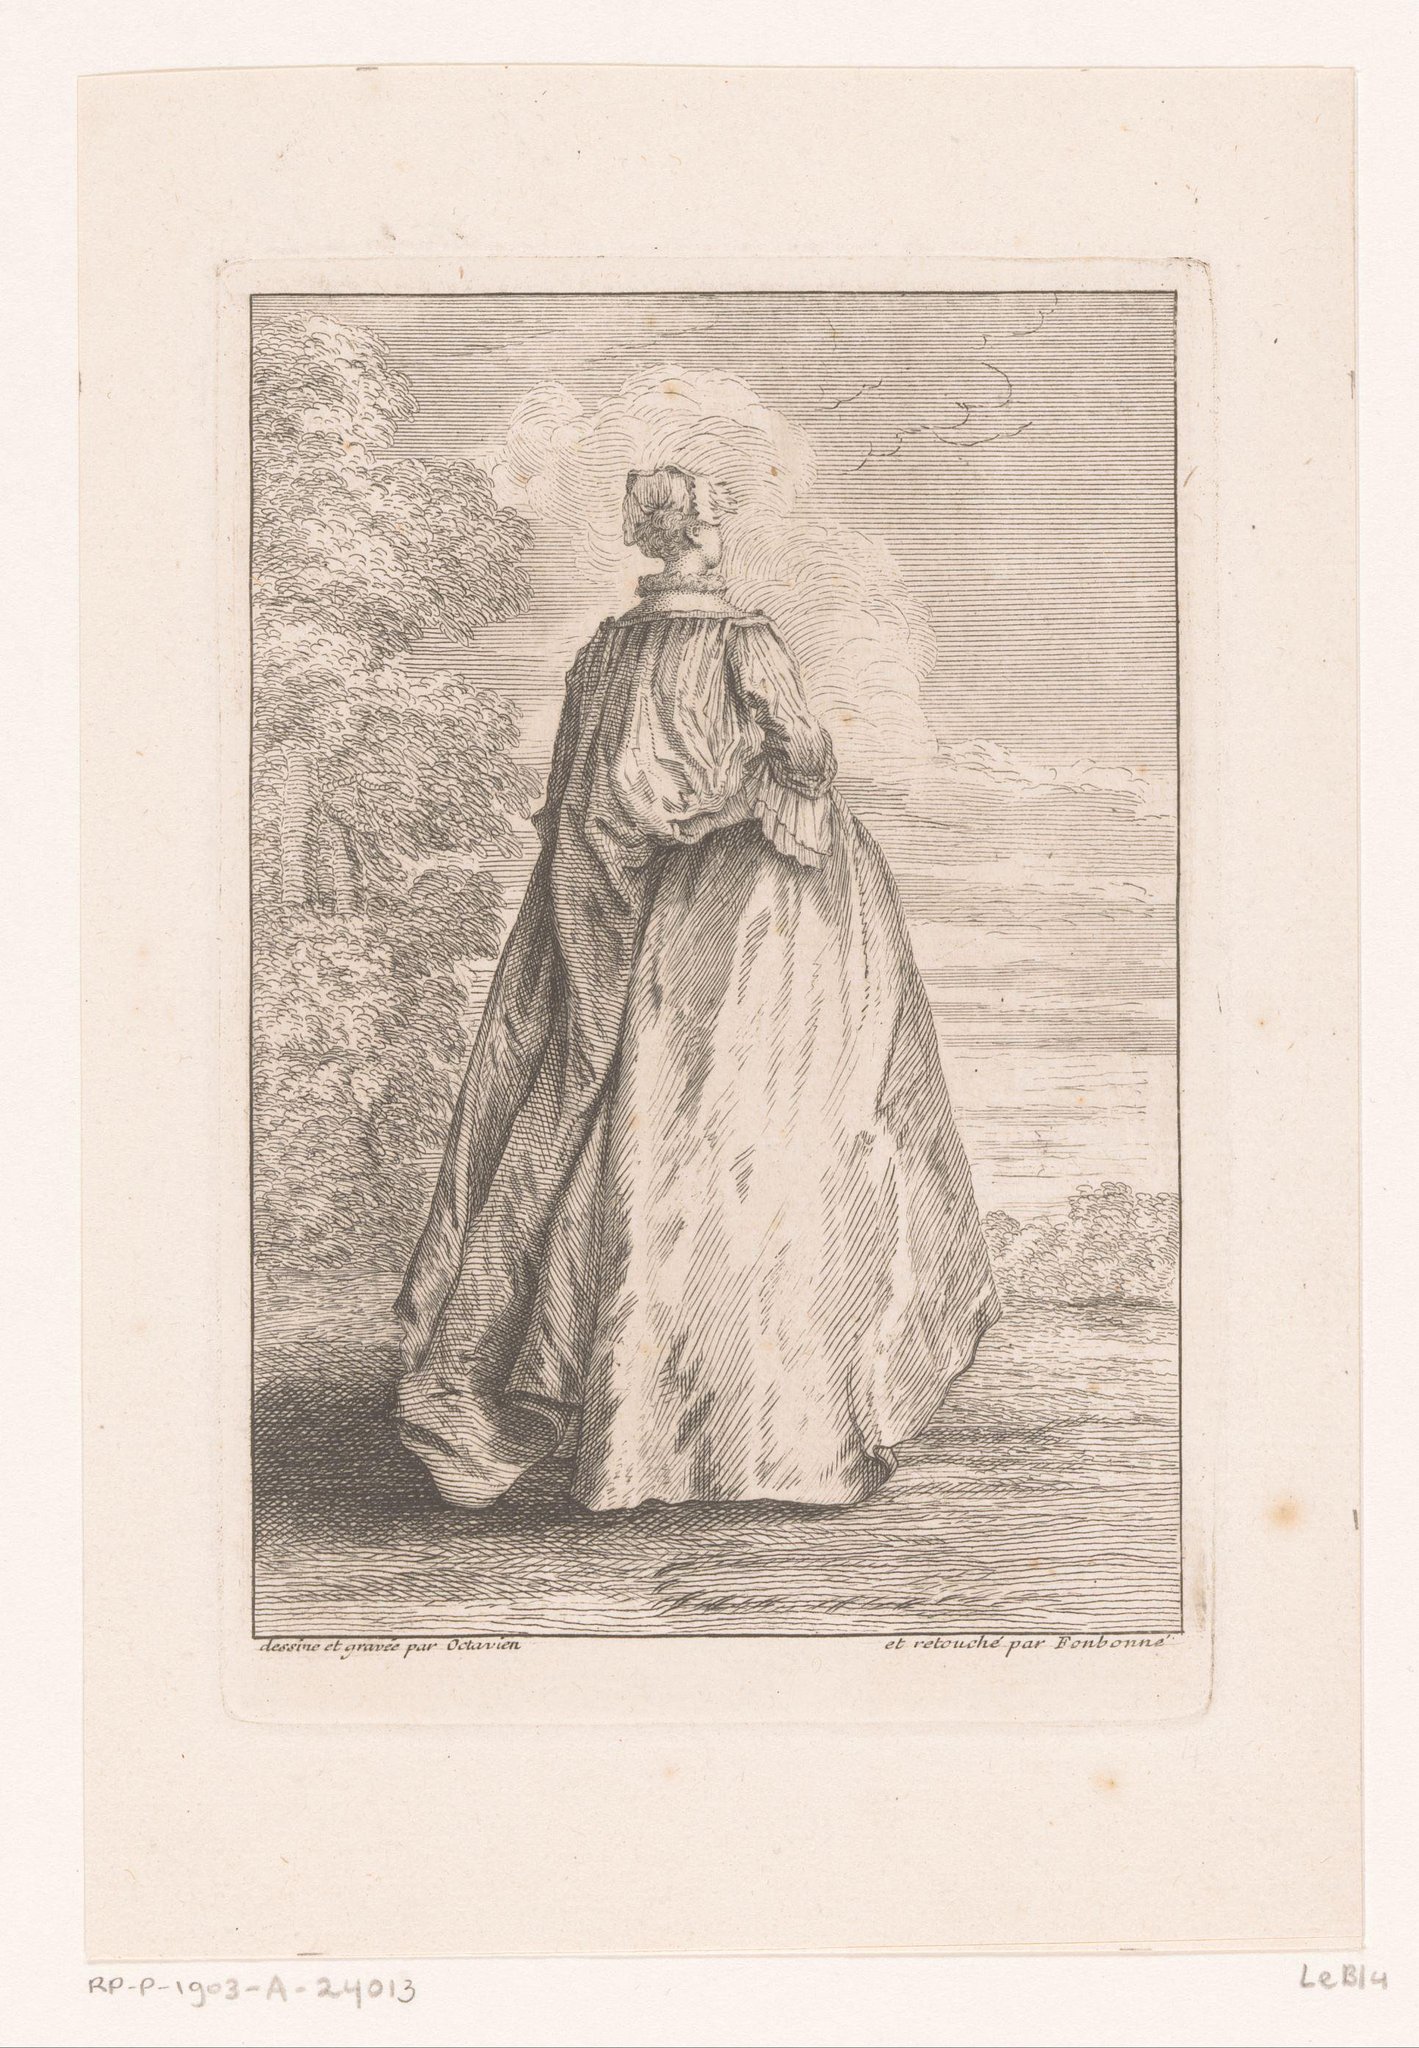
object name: costume print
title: Fashion and Elegance: French Fashions of the 1720s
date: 1725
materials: paper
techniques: engraving, etching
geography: paris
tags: landscapes, dress, gown (+ women's clothes)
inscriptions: collector's mark: Lugt 2228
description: During the early 18th century small series of costume plates reported on the fashion of the day. Women wore the loose-fitting robe volante, also called a ‘sack-backed gown’ in English, over which women sometimes added a short, hooded cloak known as a bagnolette. Men dressed in long coats over a waistcoat and knee-breeches. Pig-tail wigs were adorned with large bows, and tricorne hats were tucked under the arm rather than worn on the head. The two large prints from around 1760 show Parisians out for a stroll. Curiously, the women wear wide paniers (hoop skirts) for their promenade on the ramparts. In the caption underneath, they are condemned as silly slaves of fashion who blindly follow the dictates of the latest trends.